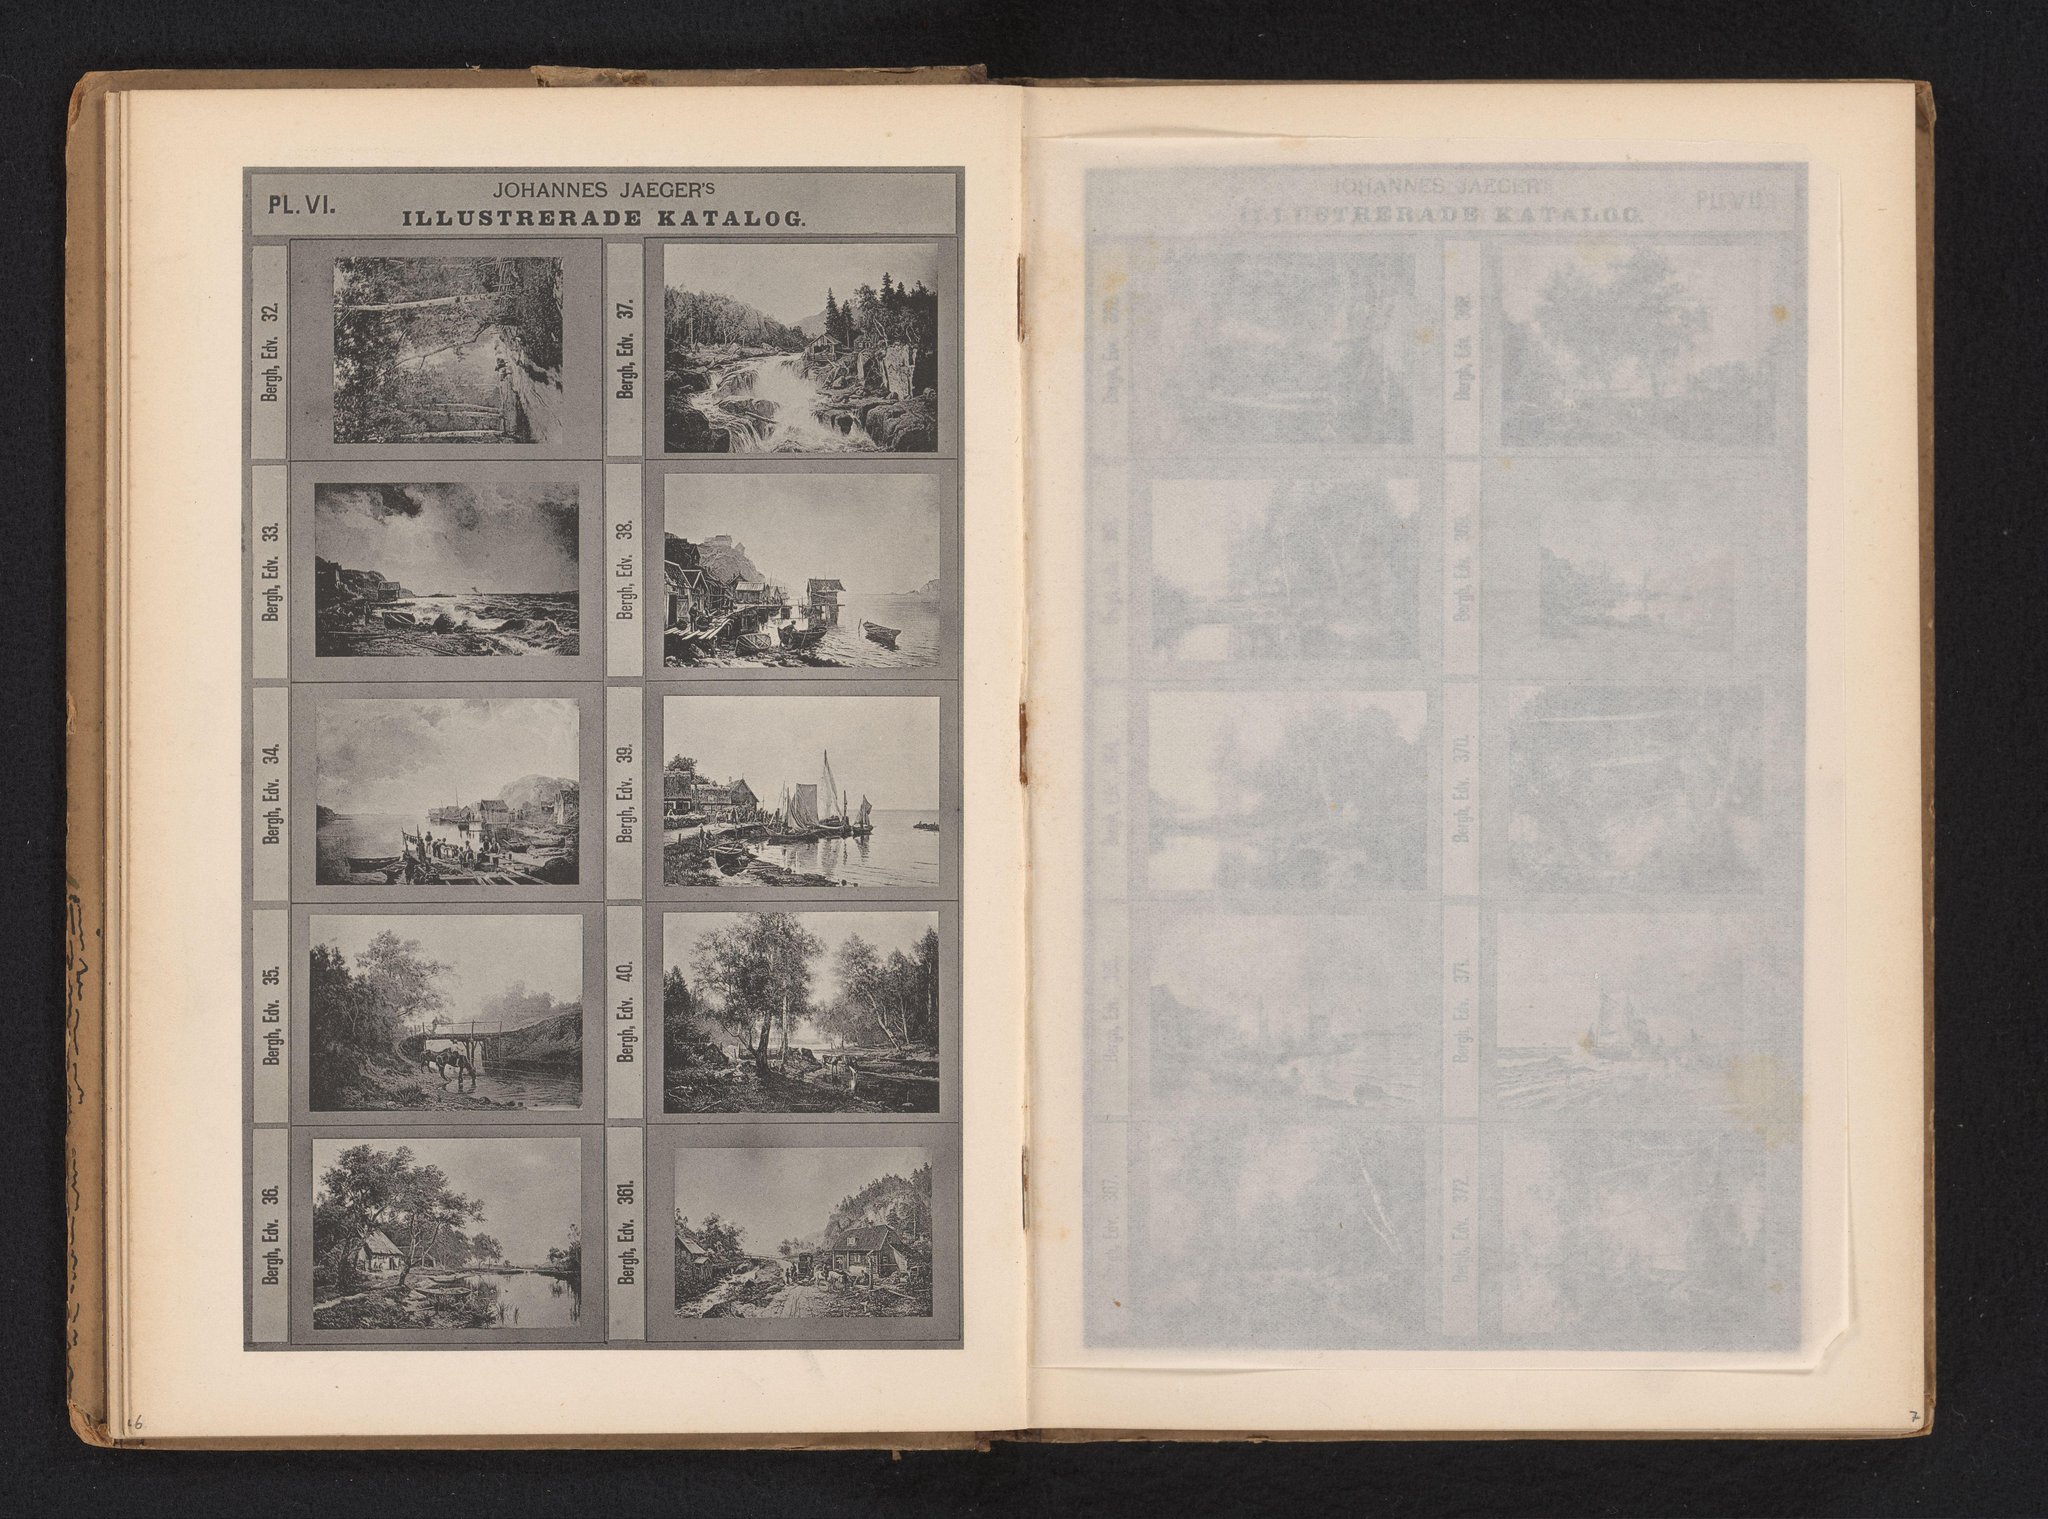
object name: page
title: Fotoreproductie van tien schilderijen van landschappen en watergezichten met boten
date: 1872-1882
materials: paper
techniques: photograph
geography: stockholm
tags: landscapes, picture, painting, traffic on the water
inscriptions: number: ‘PL. VI.’